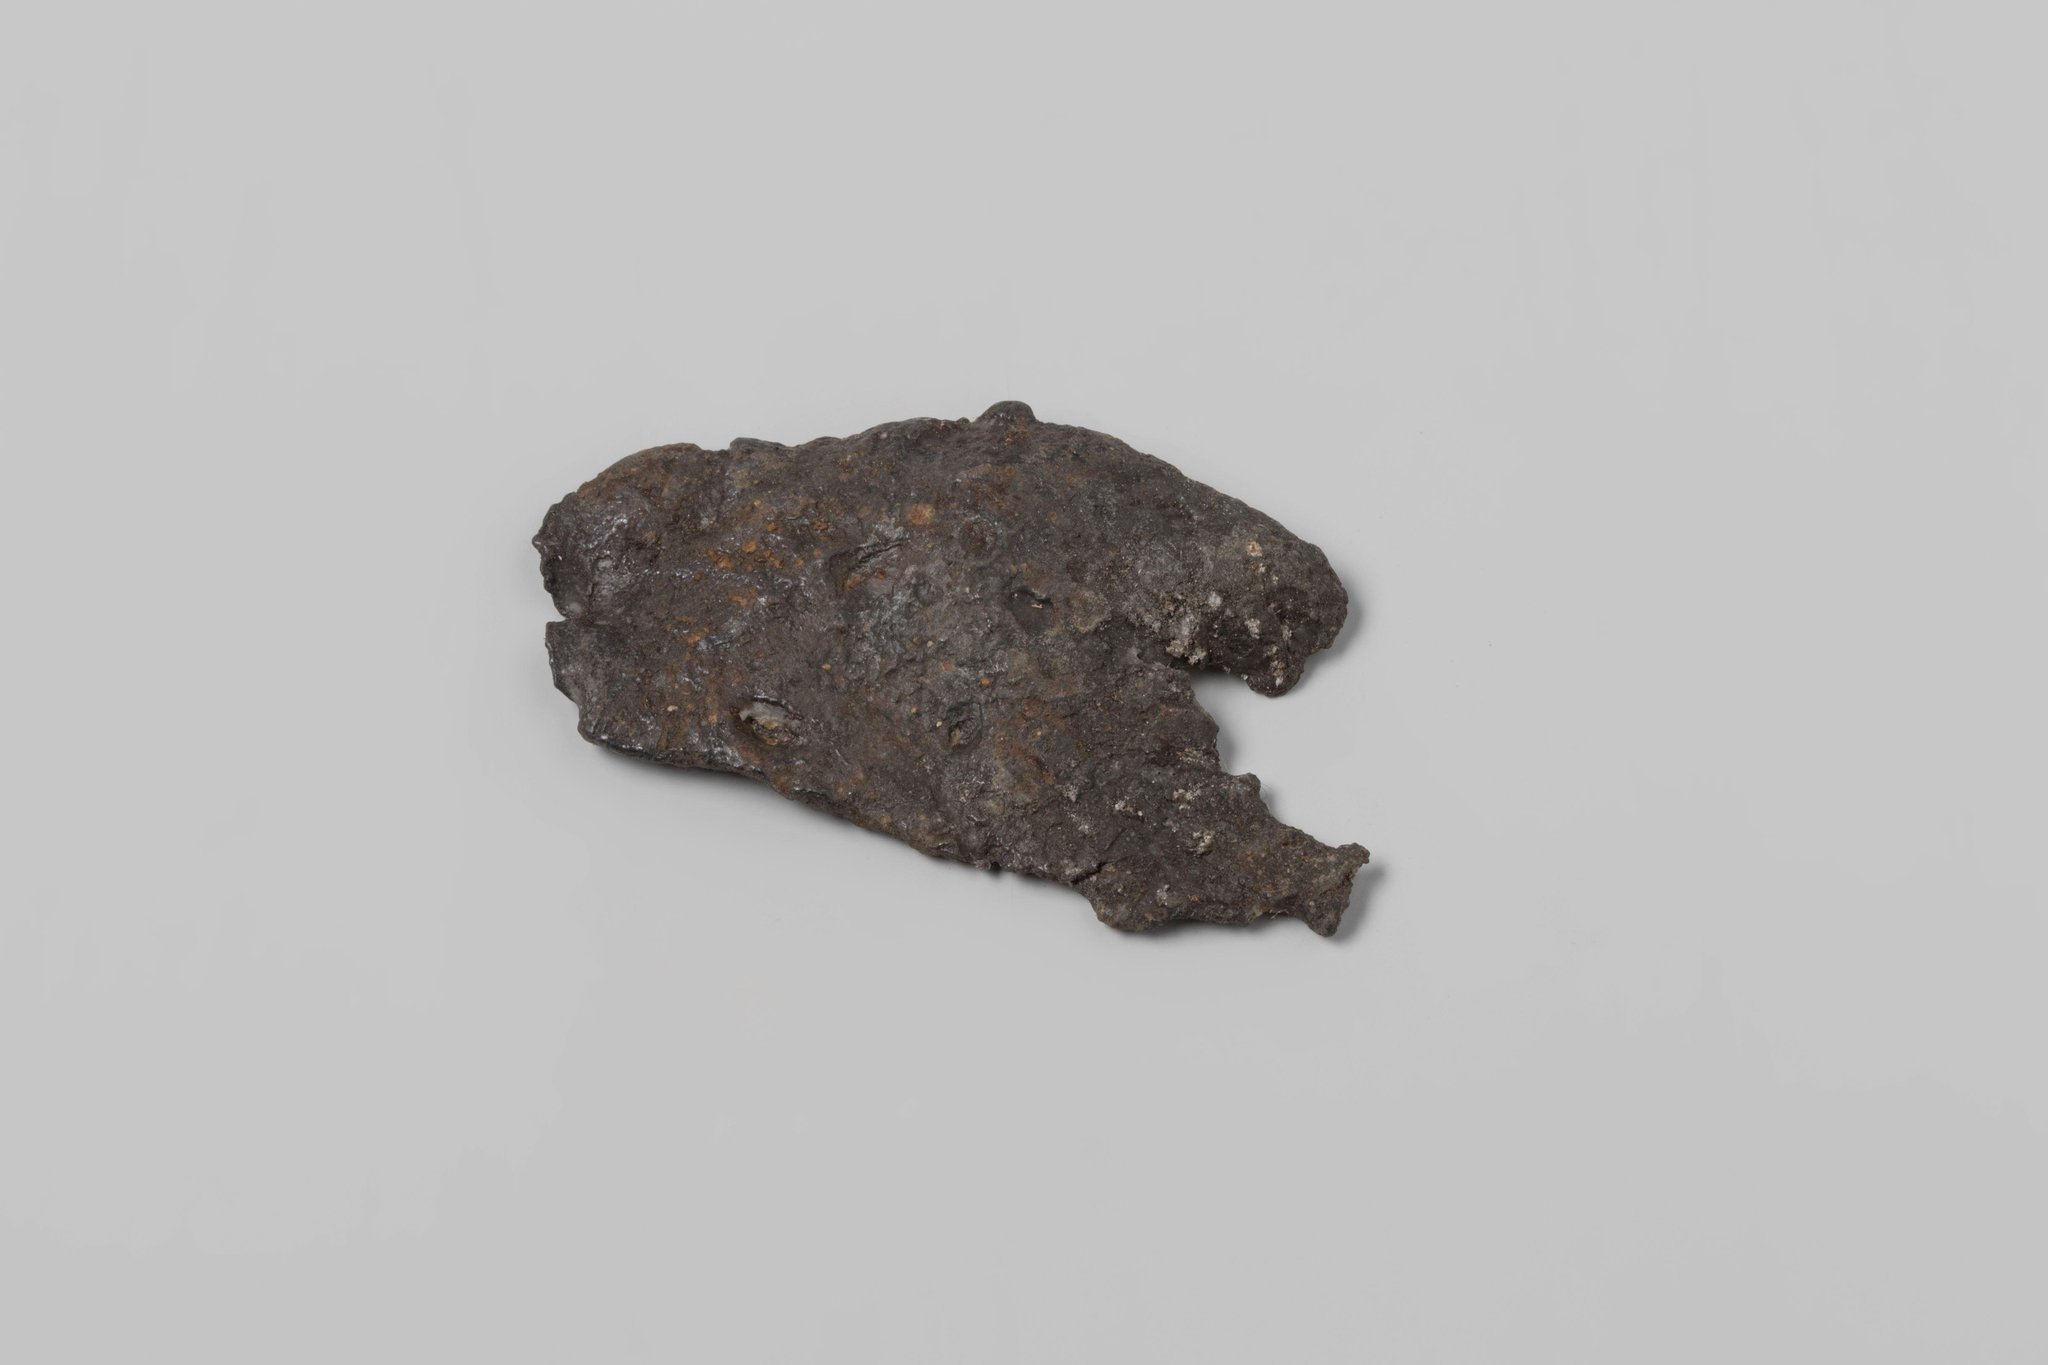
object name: scheepswrakvondst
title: Fragment lood uit het wrak van de Oost-Indiëvaarder Hollandia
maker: Anonymous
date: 1700-1743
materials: lead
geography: netherlands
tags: verenigde oostindische compagnie, hollandia (schip), annet